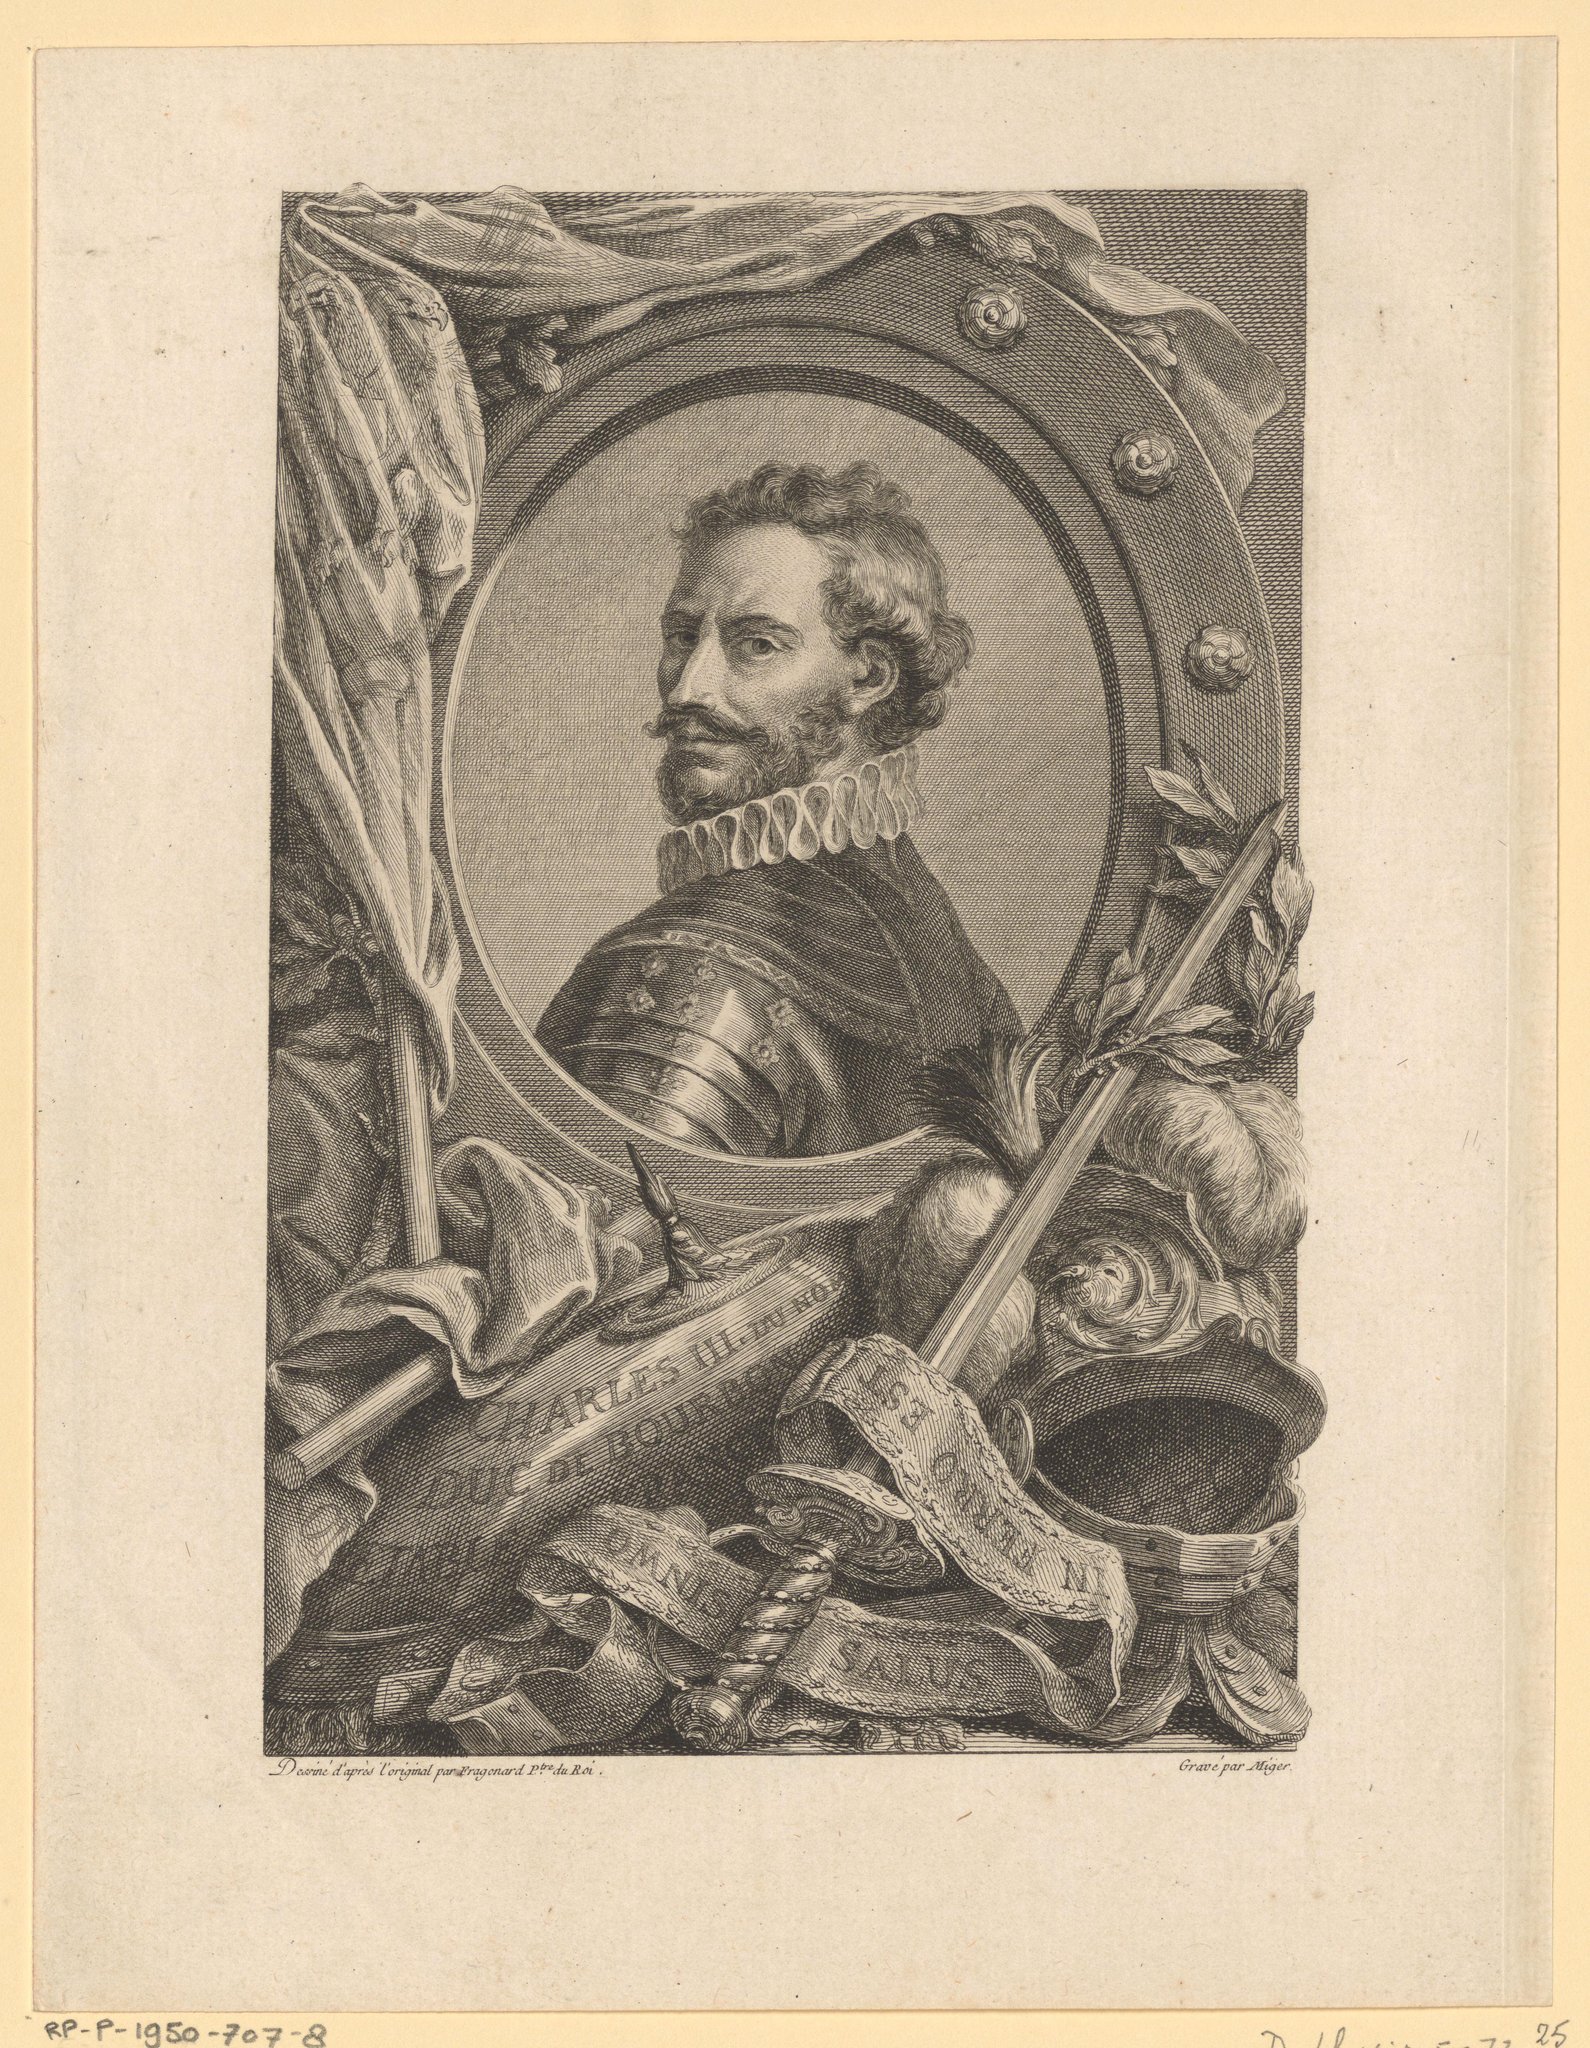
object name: book illustration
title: Portret van Karel III, hertog van Bourbon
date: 1776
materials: paper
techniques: engraving, etching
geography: paris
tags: armour, historical persons, hacking and thrusting weapons: sword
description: Prent uit: Desormeaux, Joseph-Louis-Ripault. Histoire de la Maison de Bourbon. Parijs: Imprimerie Royale, 1776, dl. 2.